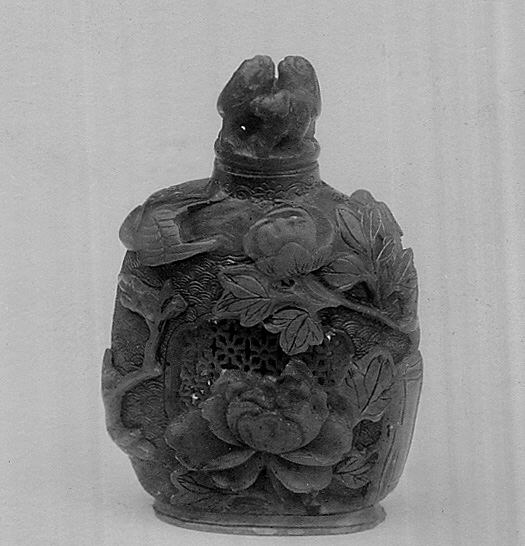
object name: snuff bottle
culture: chinese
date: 1801-1900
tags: flowers